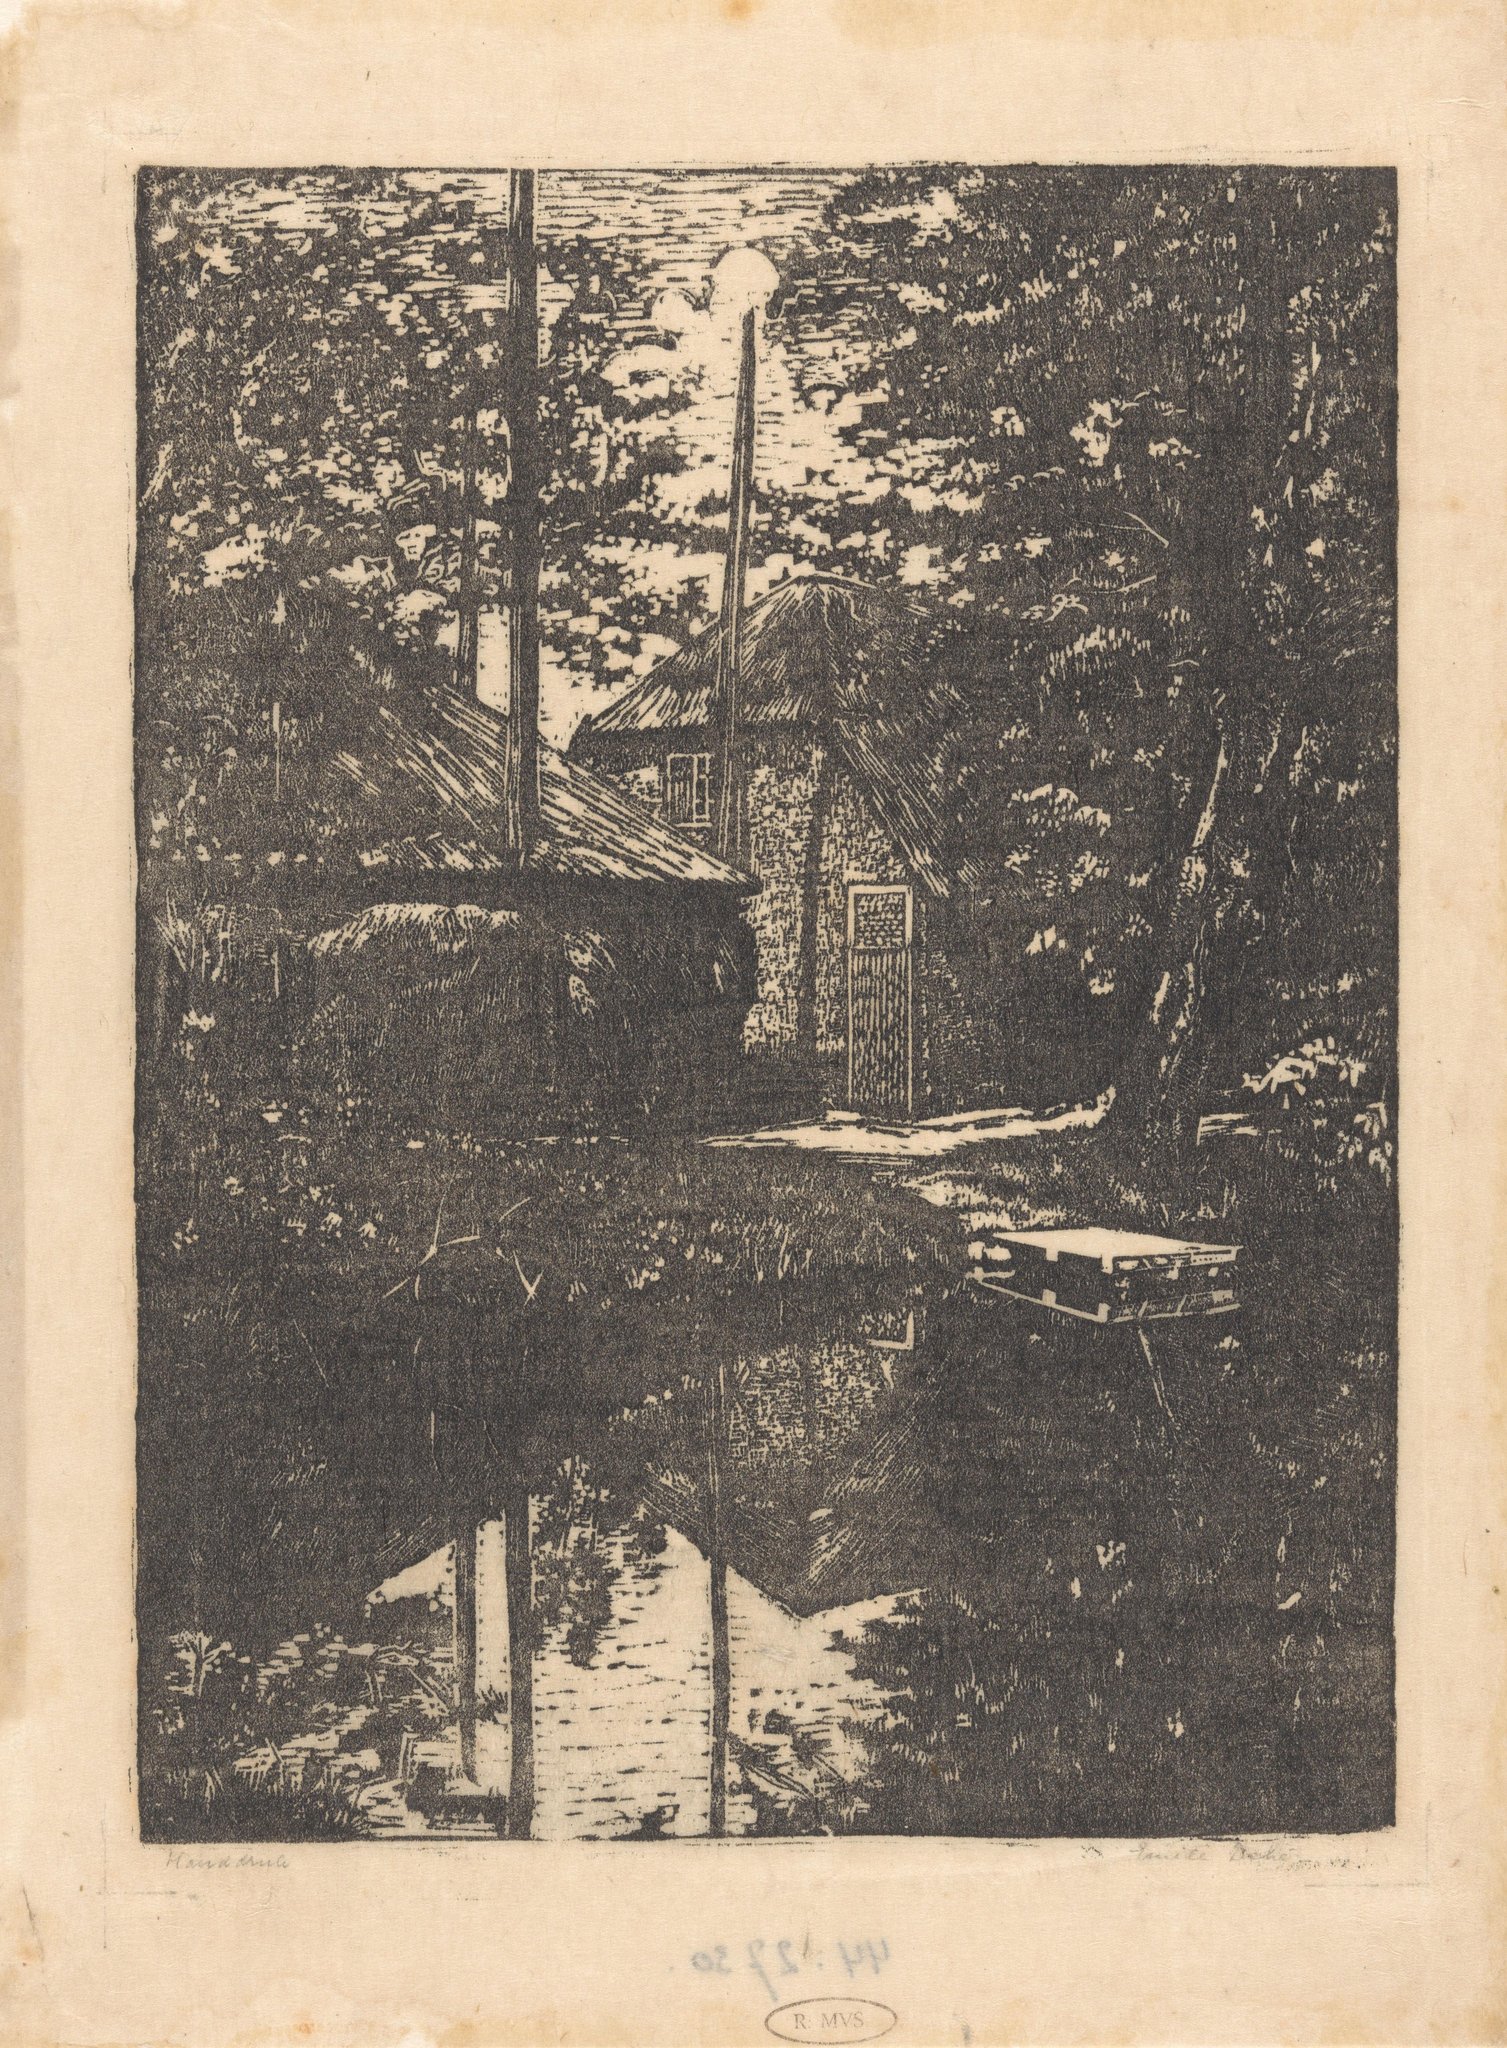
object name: print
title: Boerderij en hooischuur aan het water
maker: emilius wilhelmus dehé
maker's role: draughtsman, print maker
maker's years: 1886-1947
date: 1896-1944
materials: paper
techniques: woodcut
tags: river, farm or solitary house in landscape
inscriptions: collector's mark: Lugt 2228